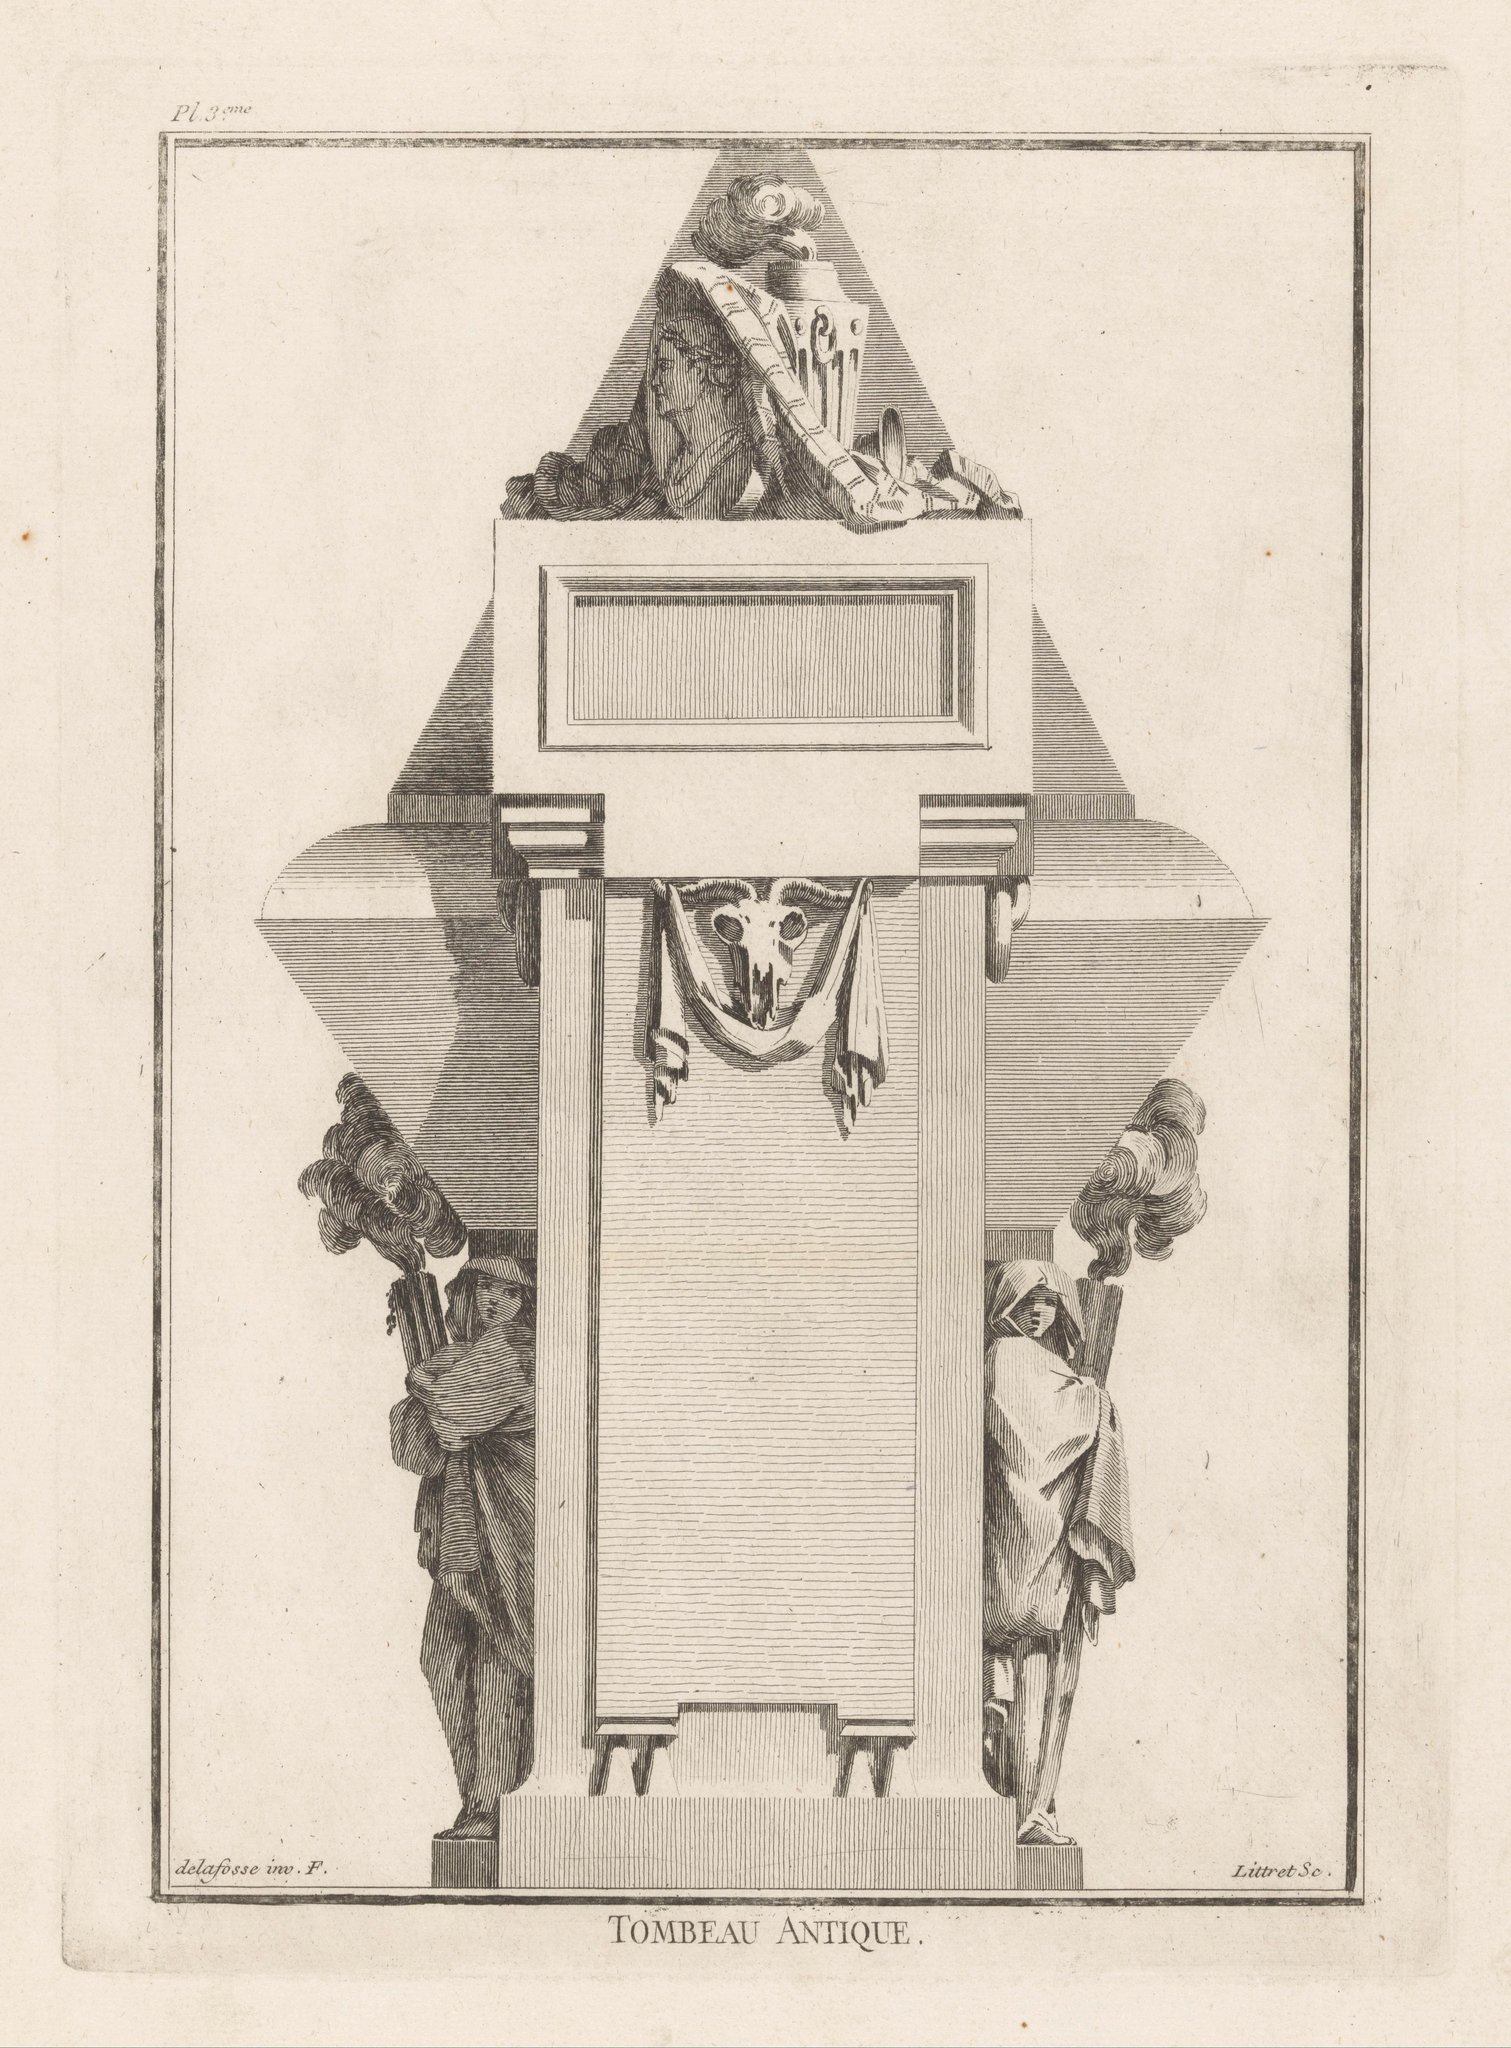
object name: ornament print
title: IIe Volume De l'Oeuvre de J. Ch. Delafosse (...)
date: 1771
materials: paper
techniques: engraving, etching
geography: paris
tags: bucranium ~ ornament, standing figure, grave, tomb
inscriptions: collector's mark: Lugt 2228, collector's mark: Lugt 2760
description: Een tombe met twee staande figuren met fakkels, een bucranium, een medaillon en een rookvat.